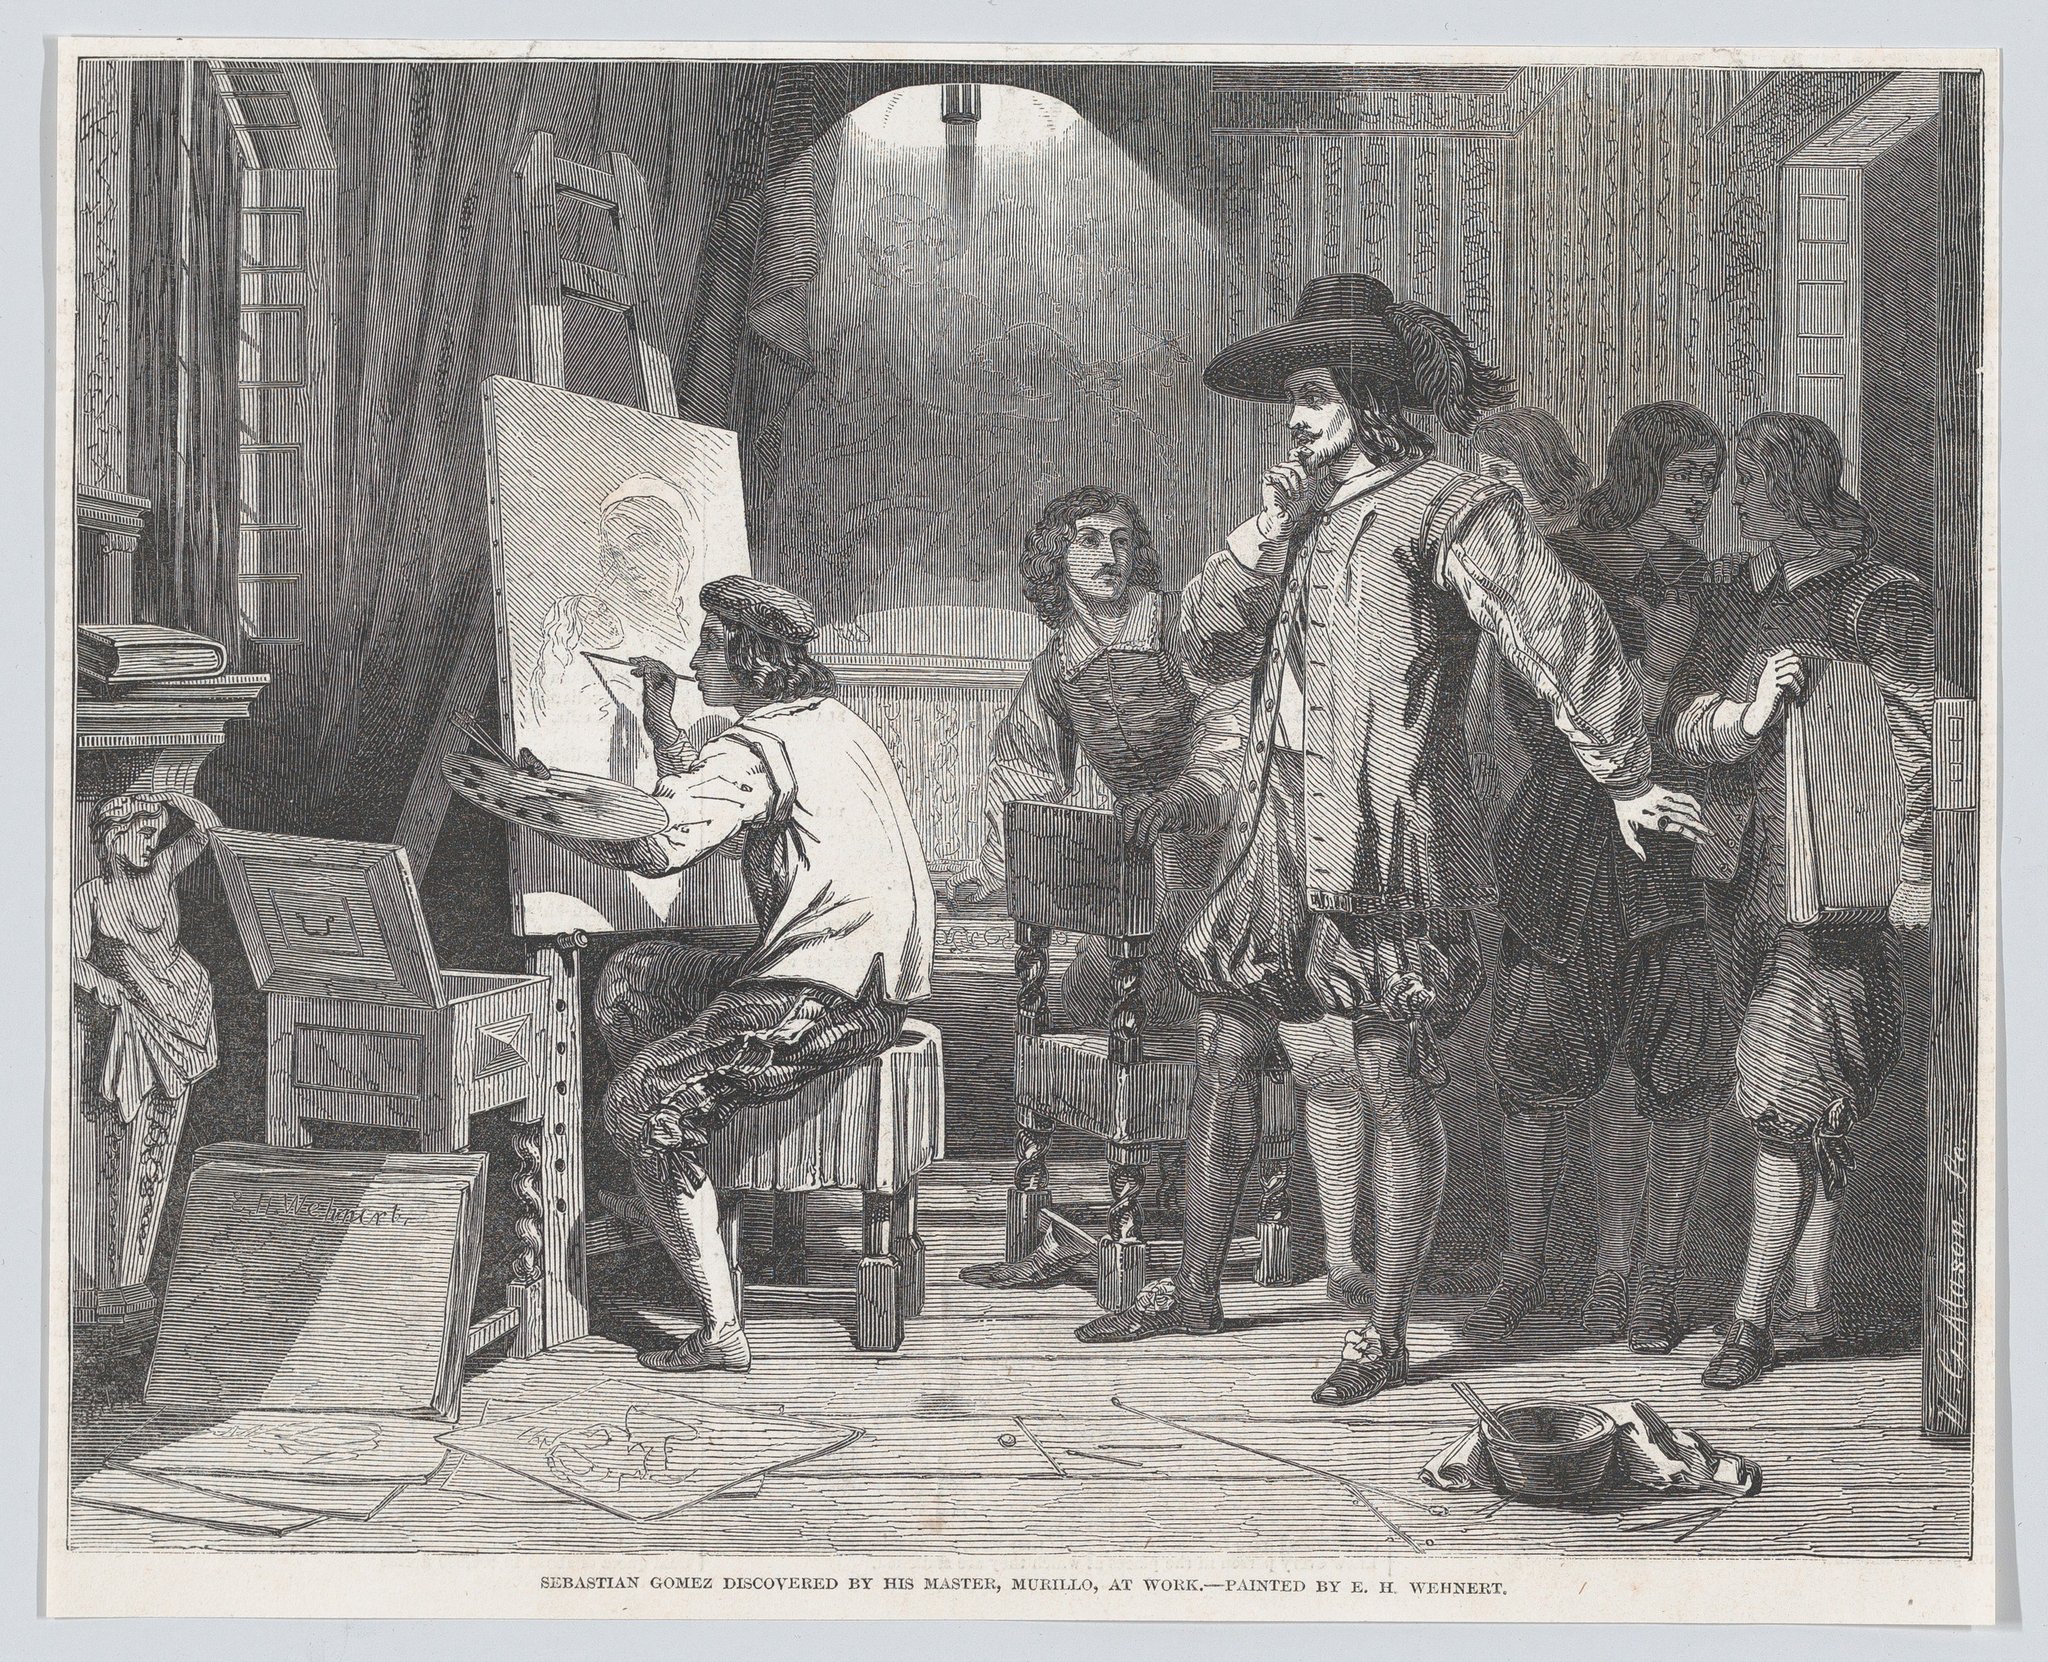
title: Sebastian Gomez Discovered by His Master Murillo, At Work, from "Illustrated London News"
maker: walter george mason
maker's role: engraver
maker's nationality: british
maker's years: 1820-1866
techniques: engraving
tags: painting,men